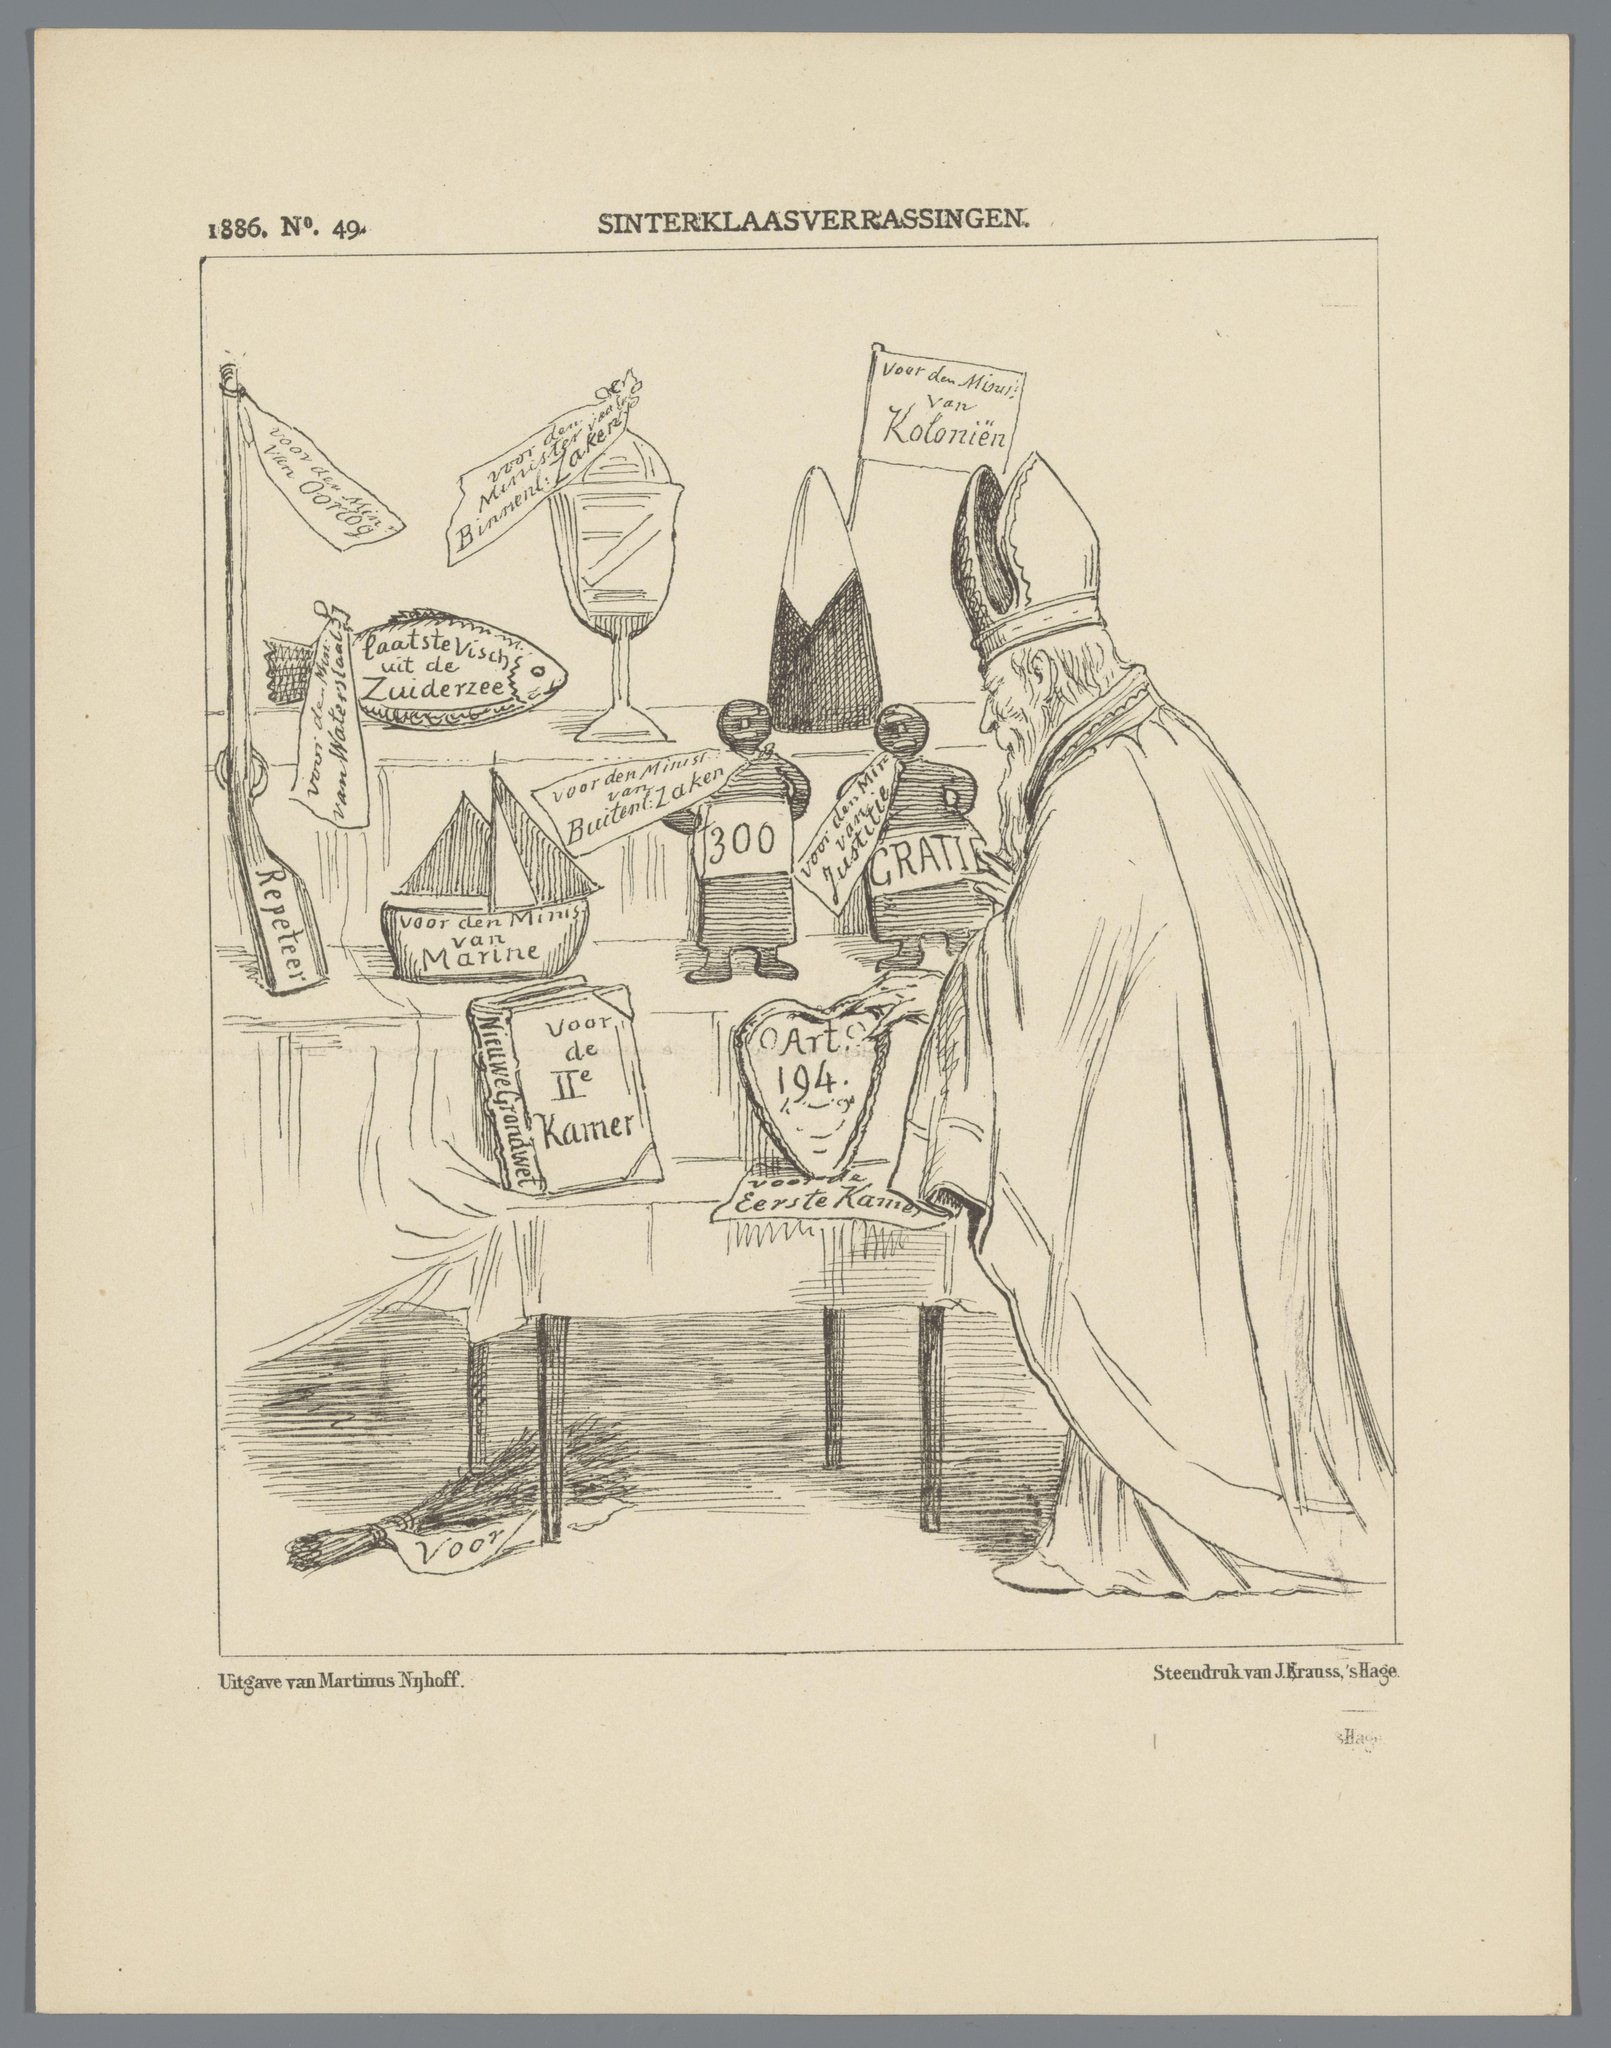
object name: print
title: Politieke spotprent met Sinterklaas, 1886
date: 1886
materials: paper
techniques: lithograph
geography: the hague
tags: festivities on st. nicholas (eve) (december 5)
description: Politieke spotprent waarin Sinterklaas geschenken klaar zet. Plaat verschenen bij het weekblad De Nederlandsche Spectator, nr. 49, 1886.